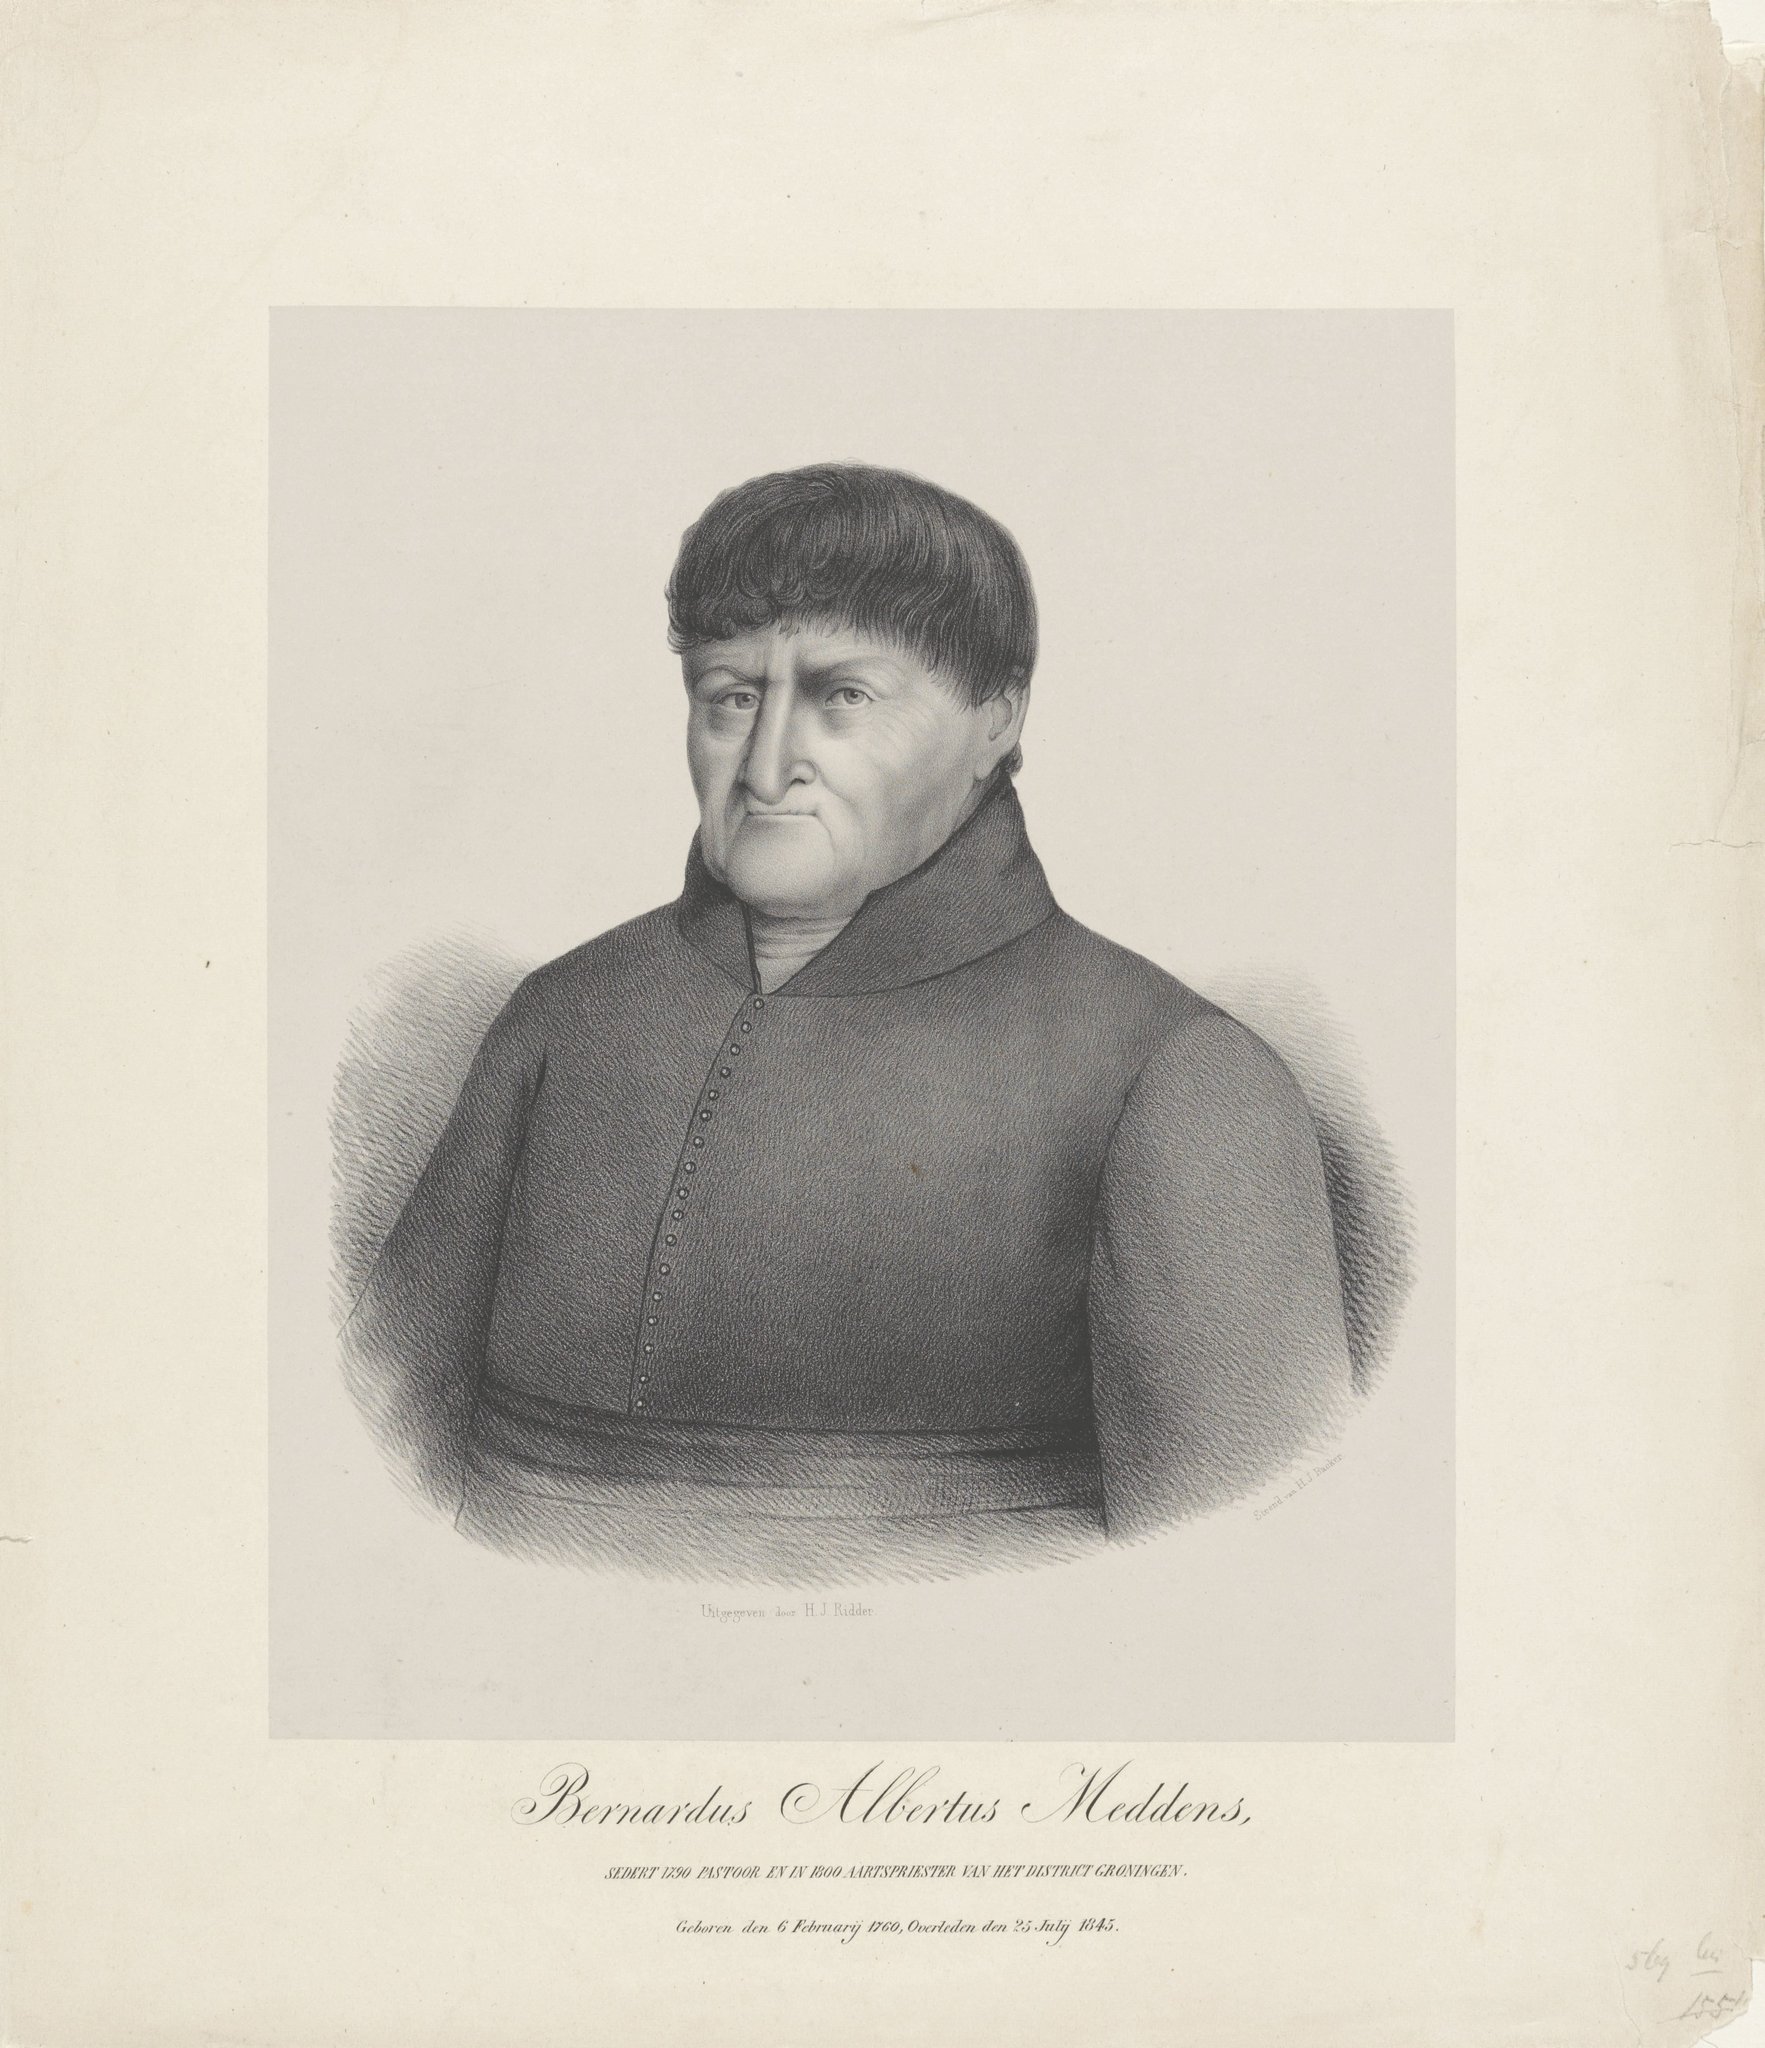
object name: print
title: Portret van Bernardus Albertus Meddens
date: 1822-1845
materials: paper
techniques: lithograph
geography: netherlands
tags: priest, historical persons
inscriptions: collector's mark: Lugt 2228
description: Onder het portret de naam van de geportretteerde, zijn beroep en geboorte- en sterfjaar.